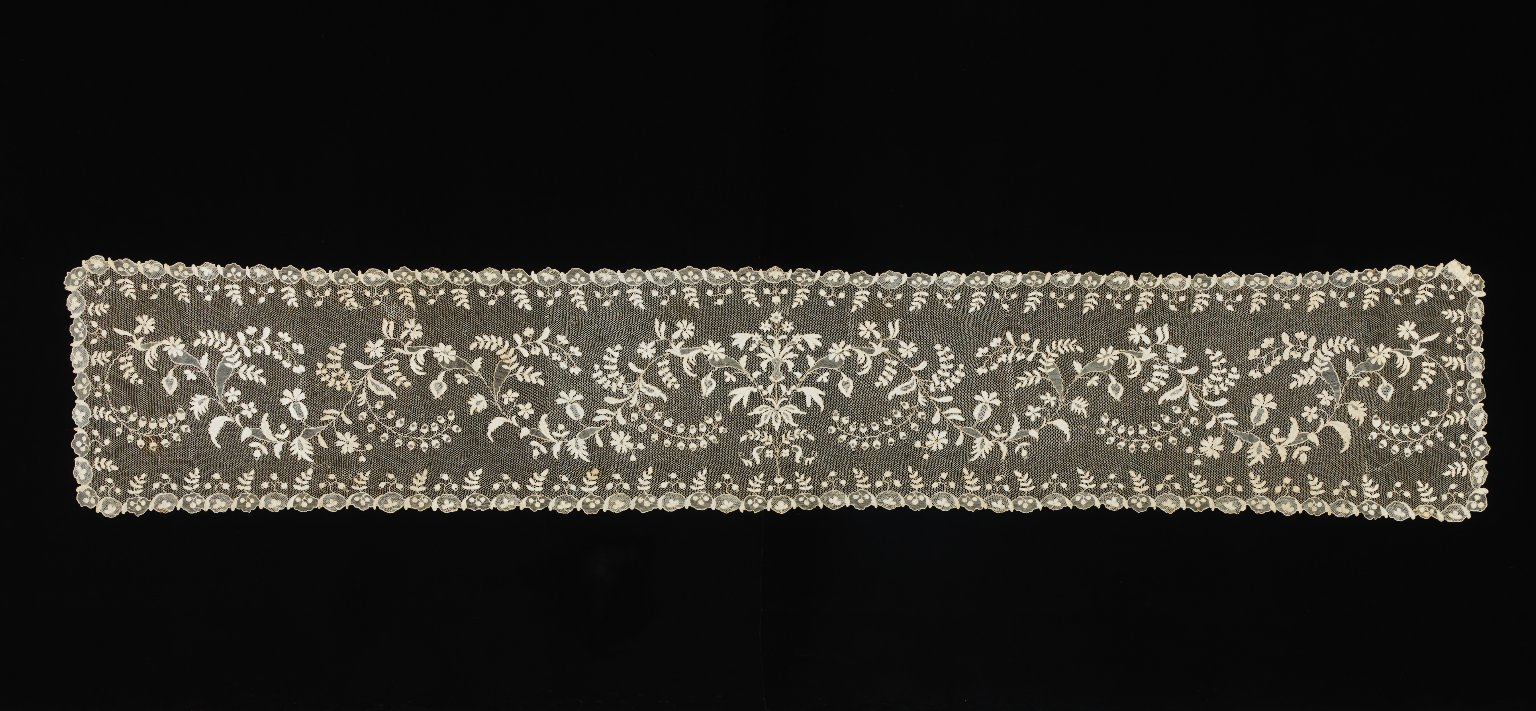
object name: scarf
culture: french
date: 1790-1810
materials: linen